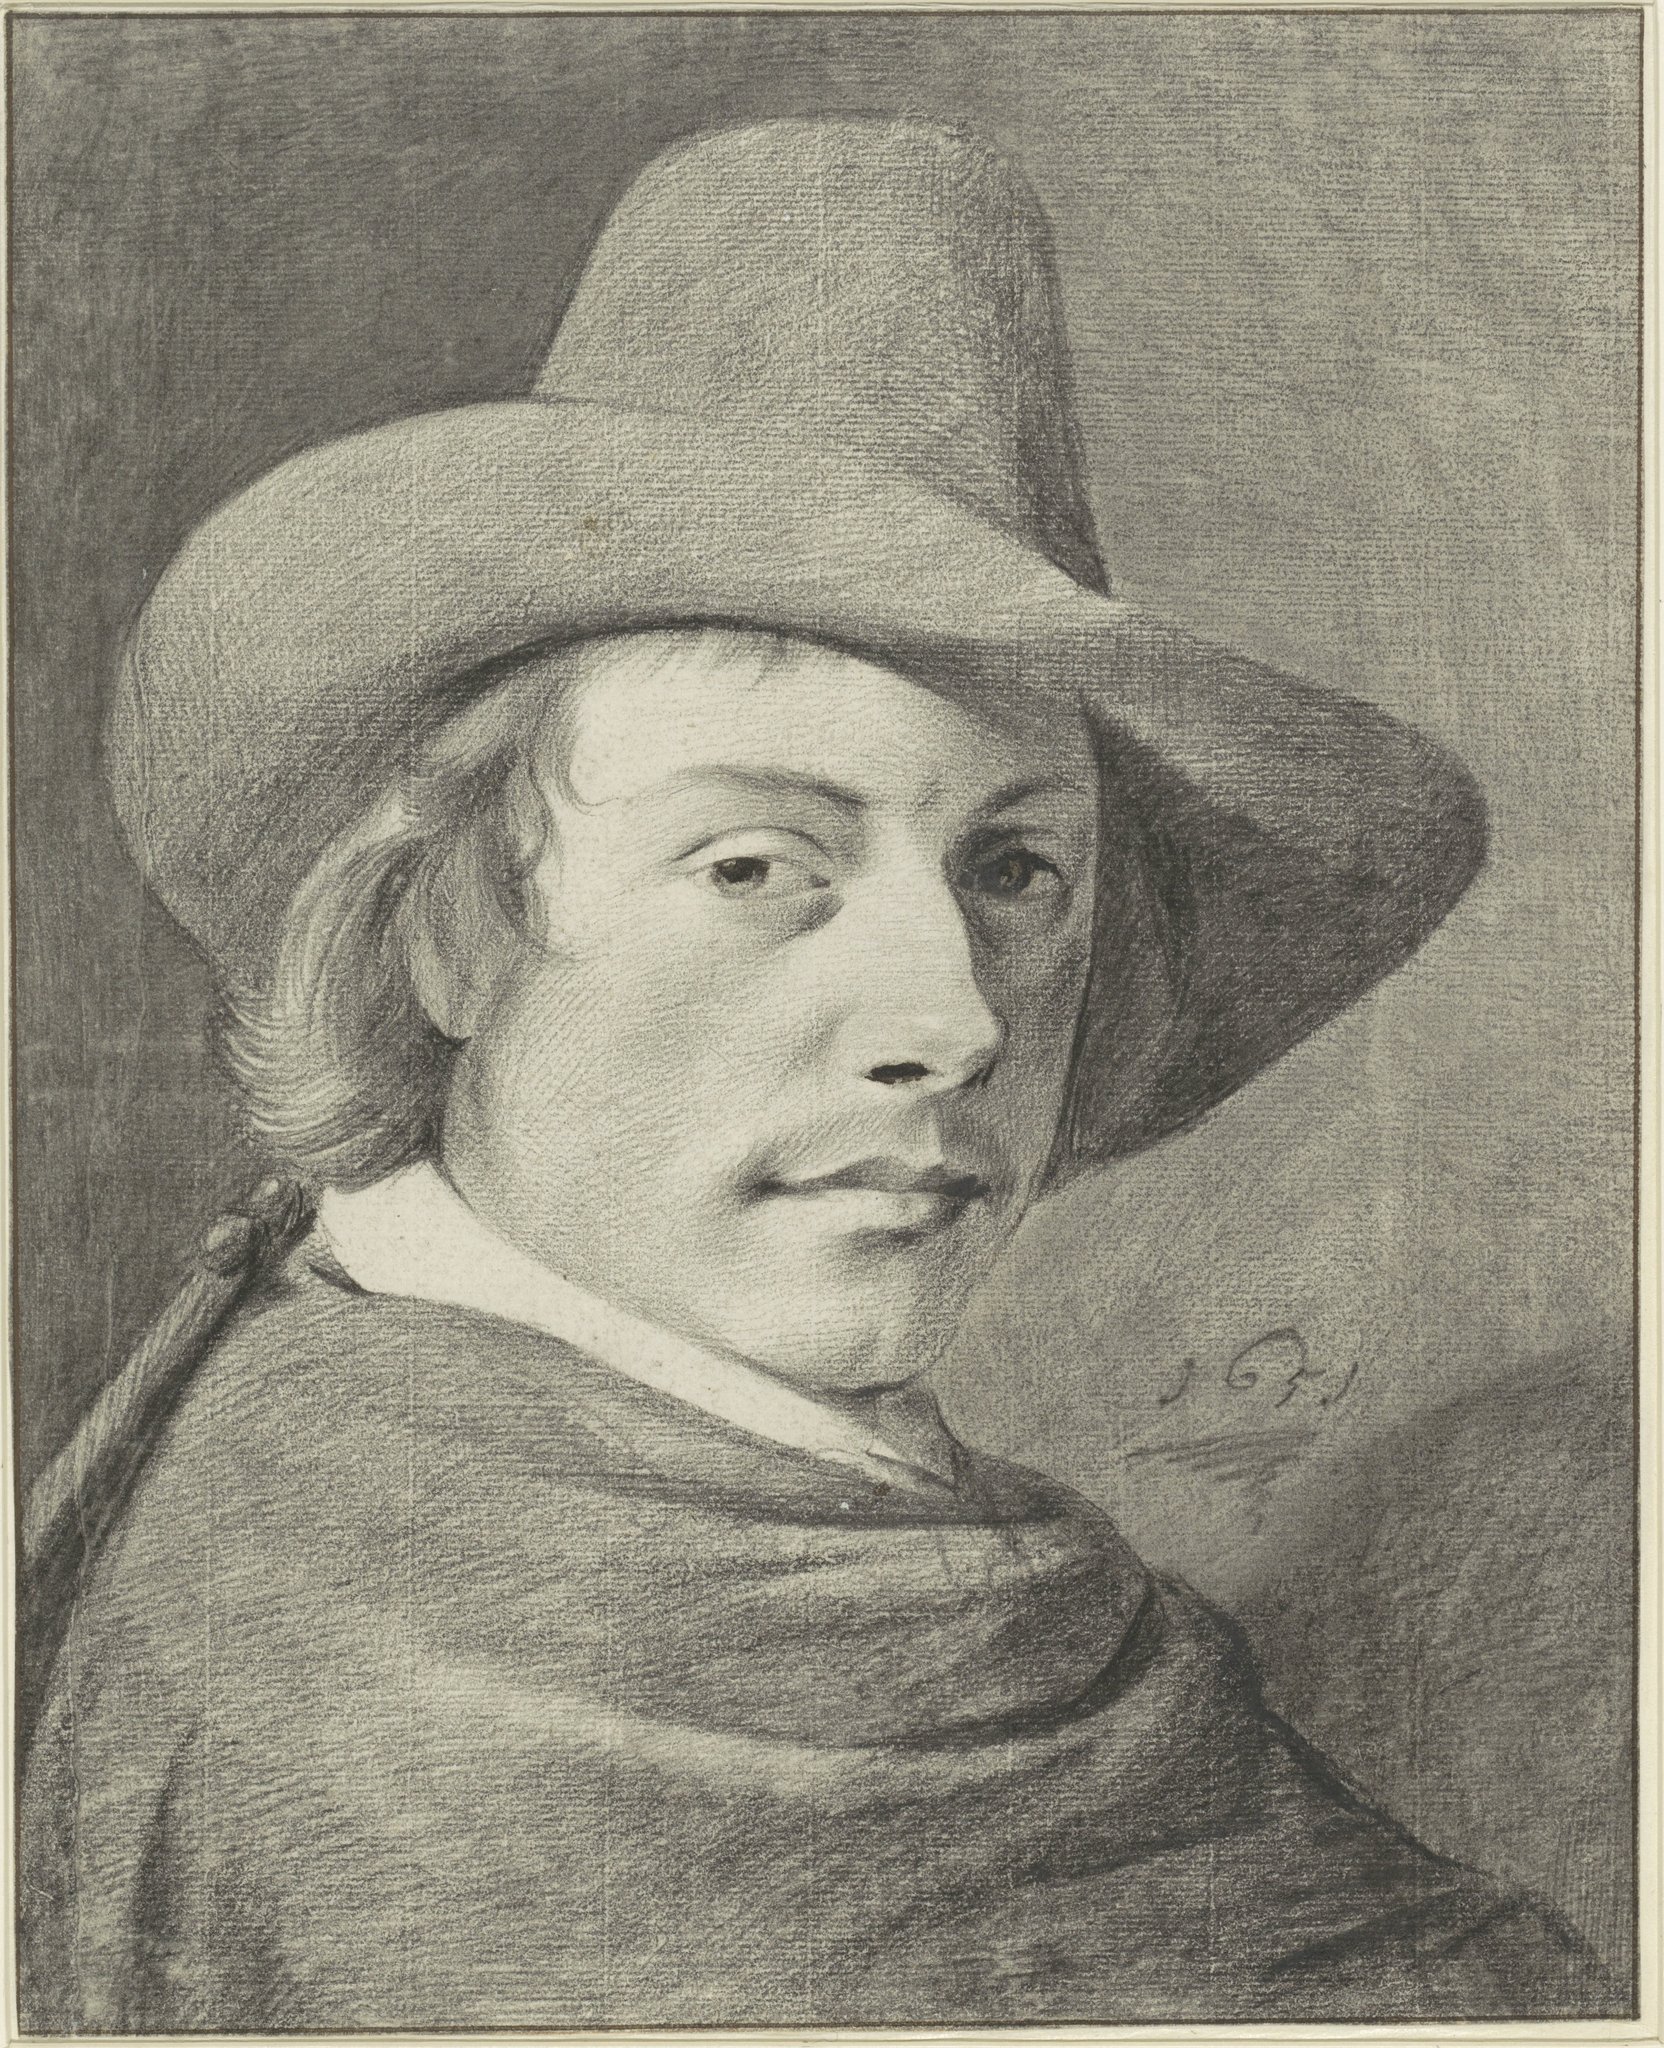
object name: drawing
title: Portret van de schilder Vincent Laurensz. van der Vinne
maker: leendert van der cooghen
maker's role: draughtsman, print maker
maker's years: 1632-1681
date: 1651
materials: chalk, paper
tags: haarlem, print maker, vincent laurensz. van der vinne (i), historical persons, portrait, self-portrait of painter, portrait, self-portrait of artist